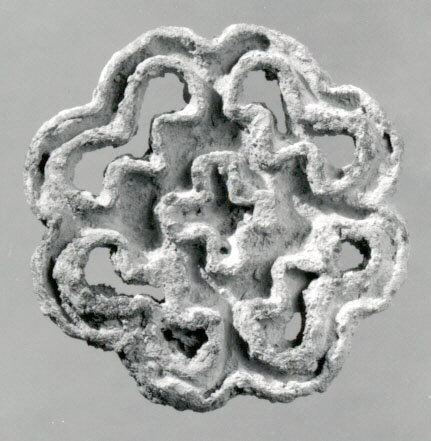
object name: stamp seal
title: Compartmented stamp seal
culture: bactria-margiana archaeological complex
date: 2333-1668 BCE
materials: copper alloy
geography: bactria-margiana